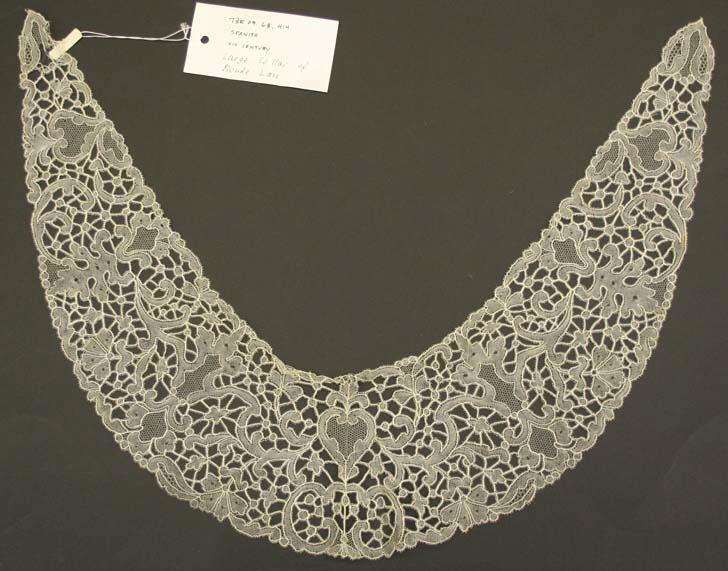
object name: collar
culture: spanish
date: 1801-1900